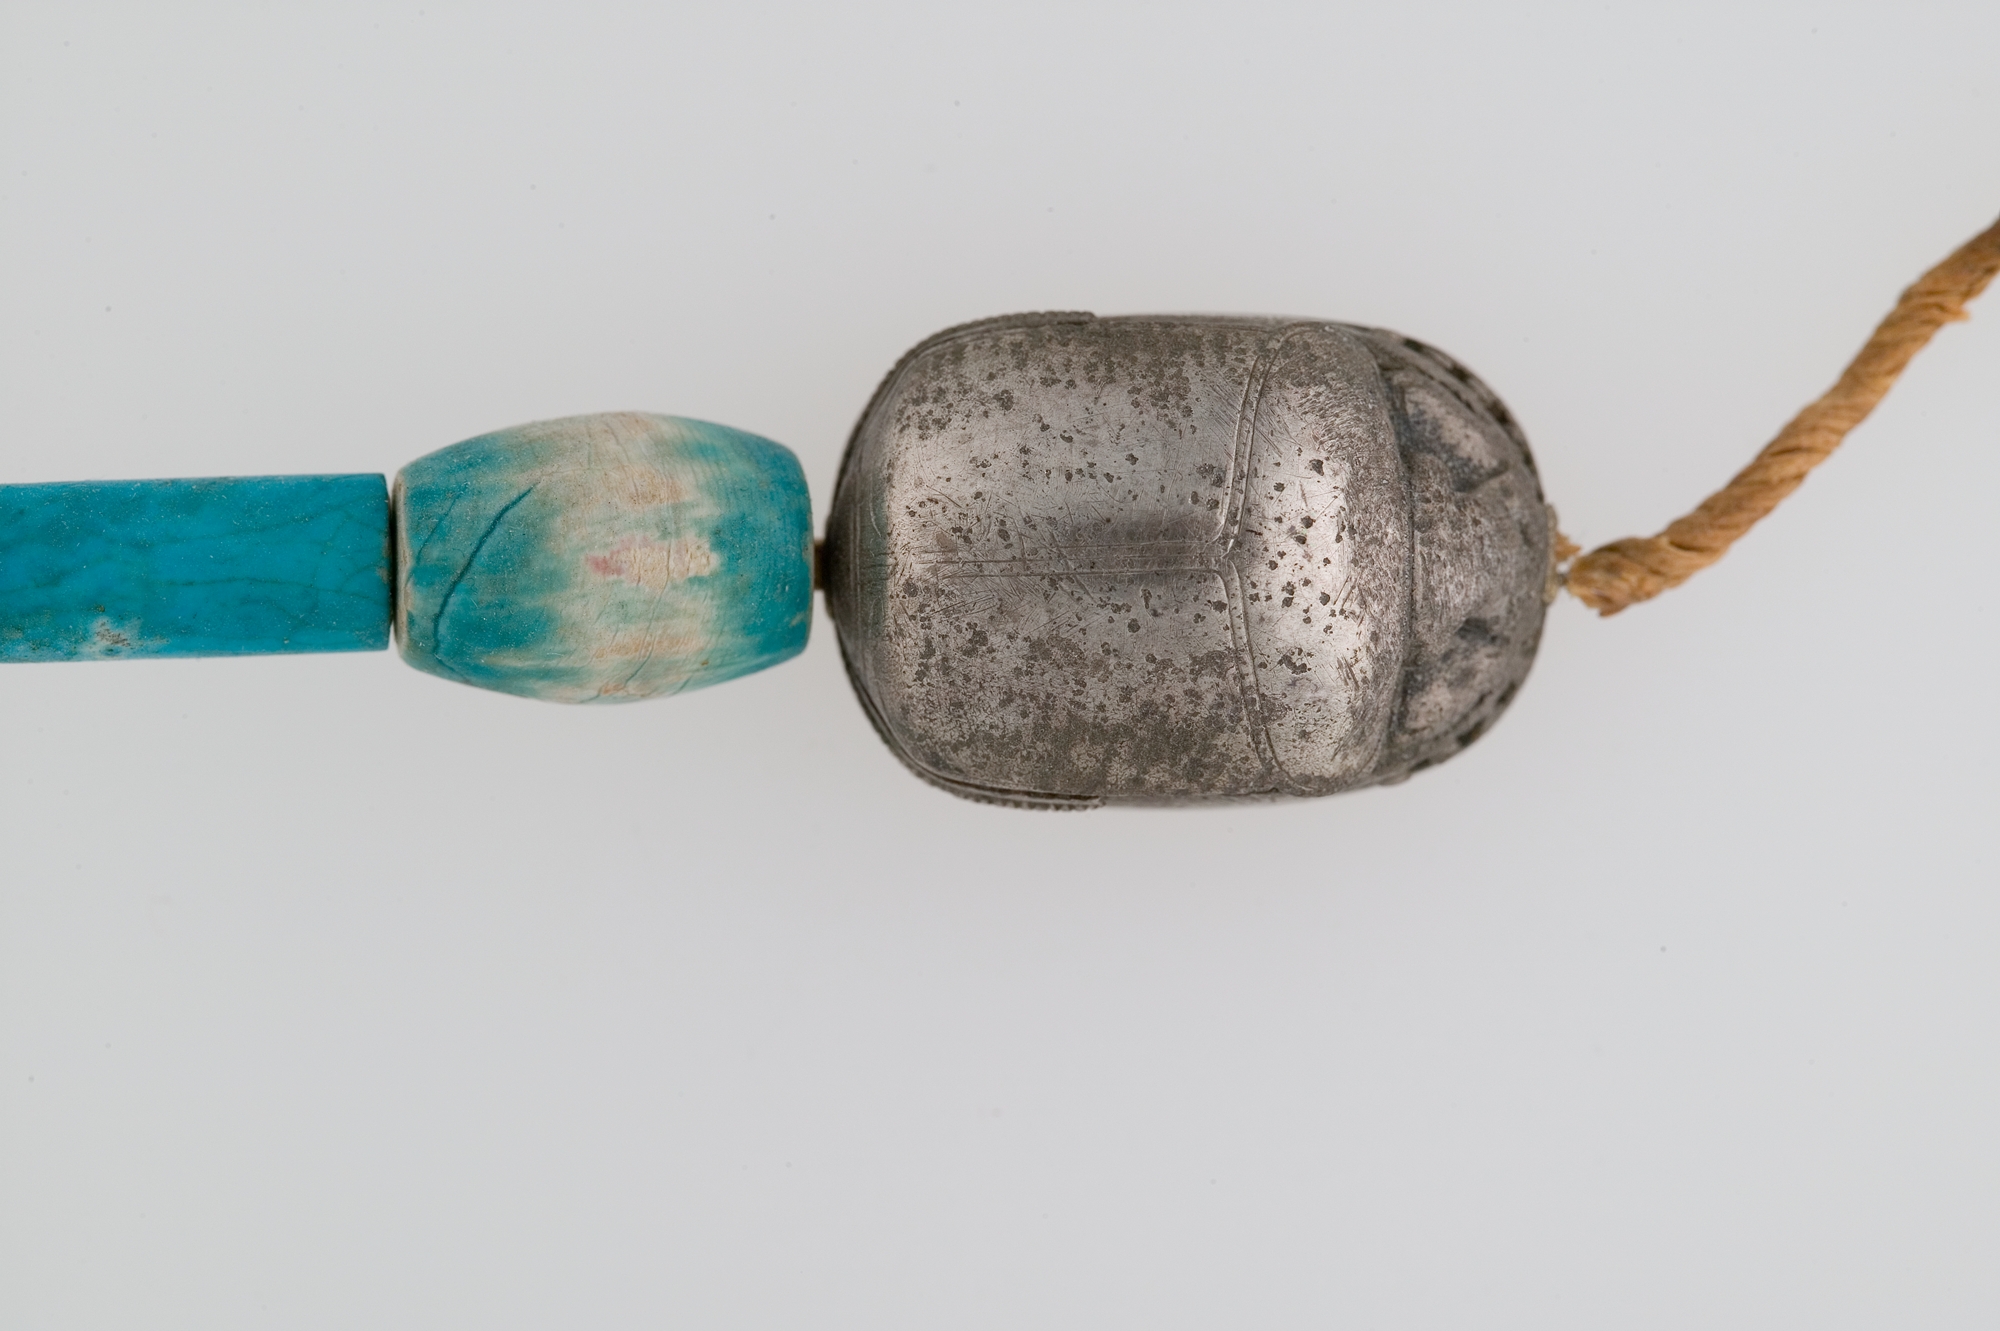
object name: scarab, bracelet, wah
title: Scarab Bracelet of Wah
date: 1981-1975 BCE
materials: cord, linen, silver, stone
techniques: glazing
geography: egypt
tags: scarabs